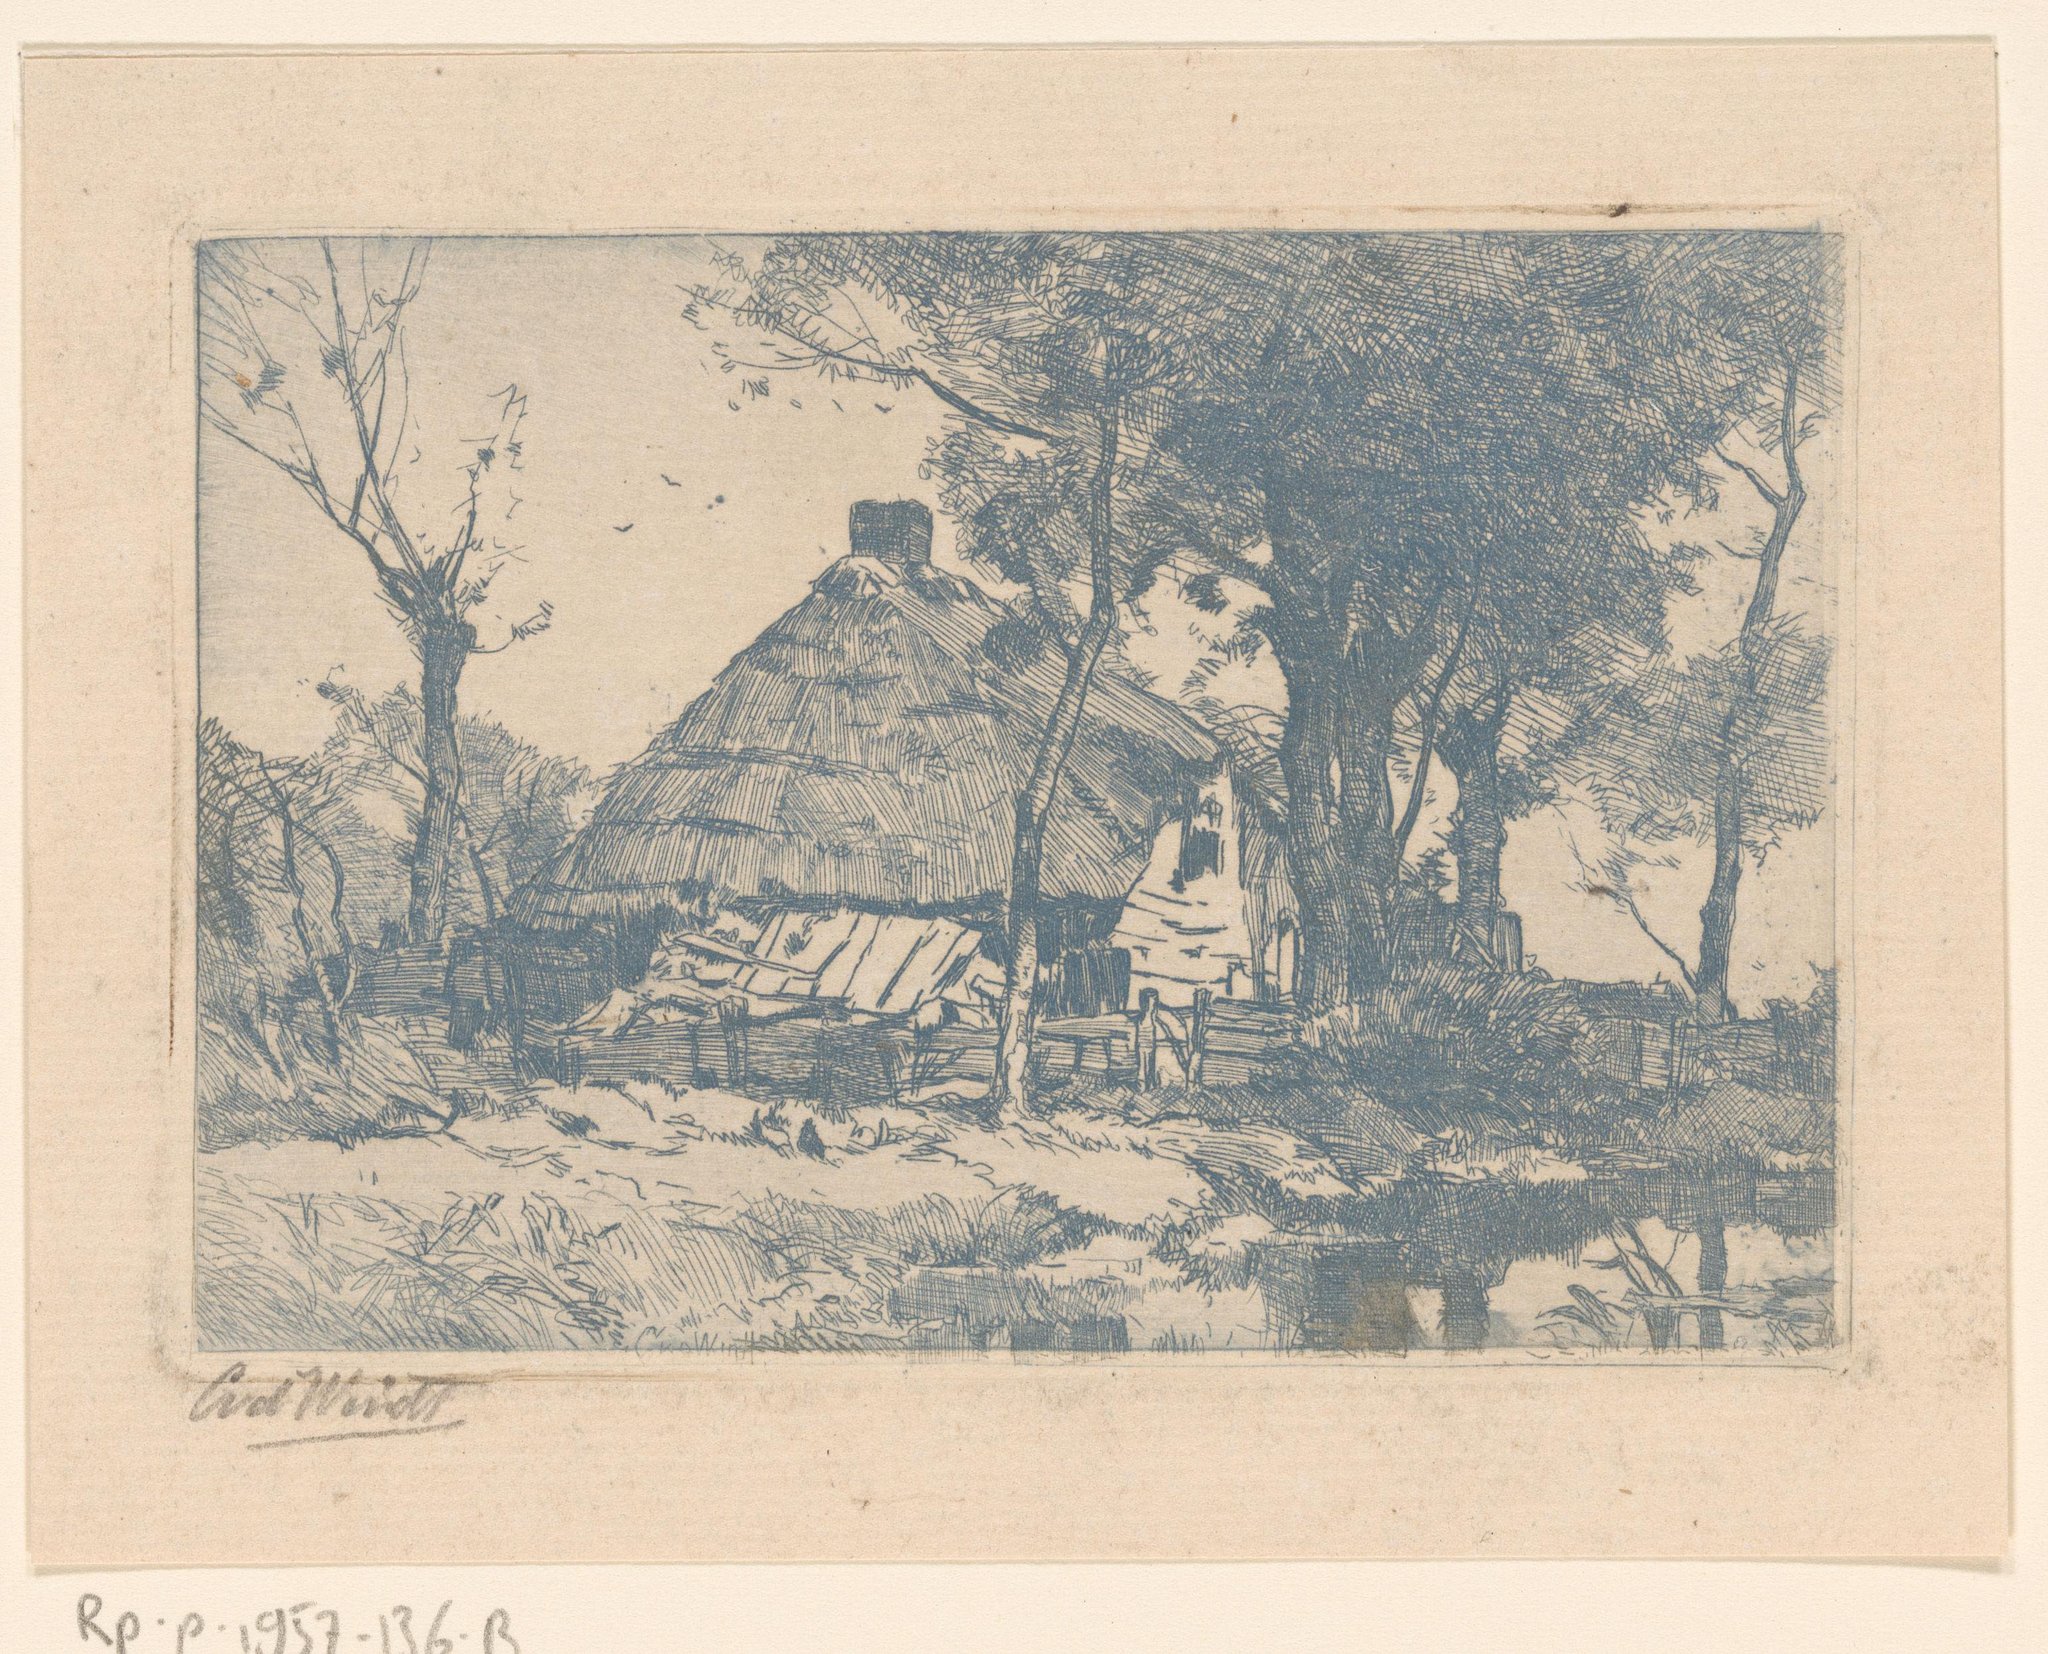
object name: print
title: Boerderij aan een plas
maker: chris van der windt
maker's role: print maker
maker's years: 1877-1952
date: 1887-1911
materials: paper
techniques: etching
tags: farm or solitary house in landscape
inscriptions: collector's mark: Lugt 2228